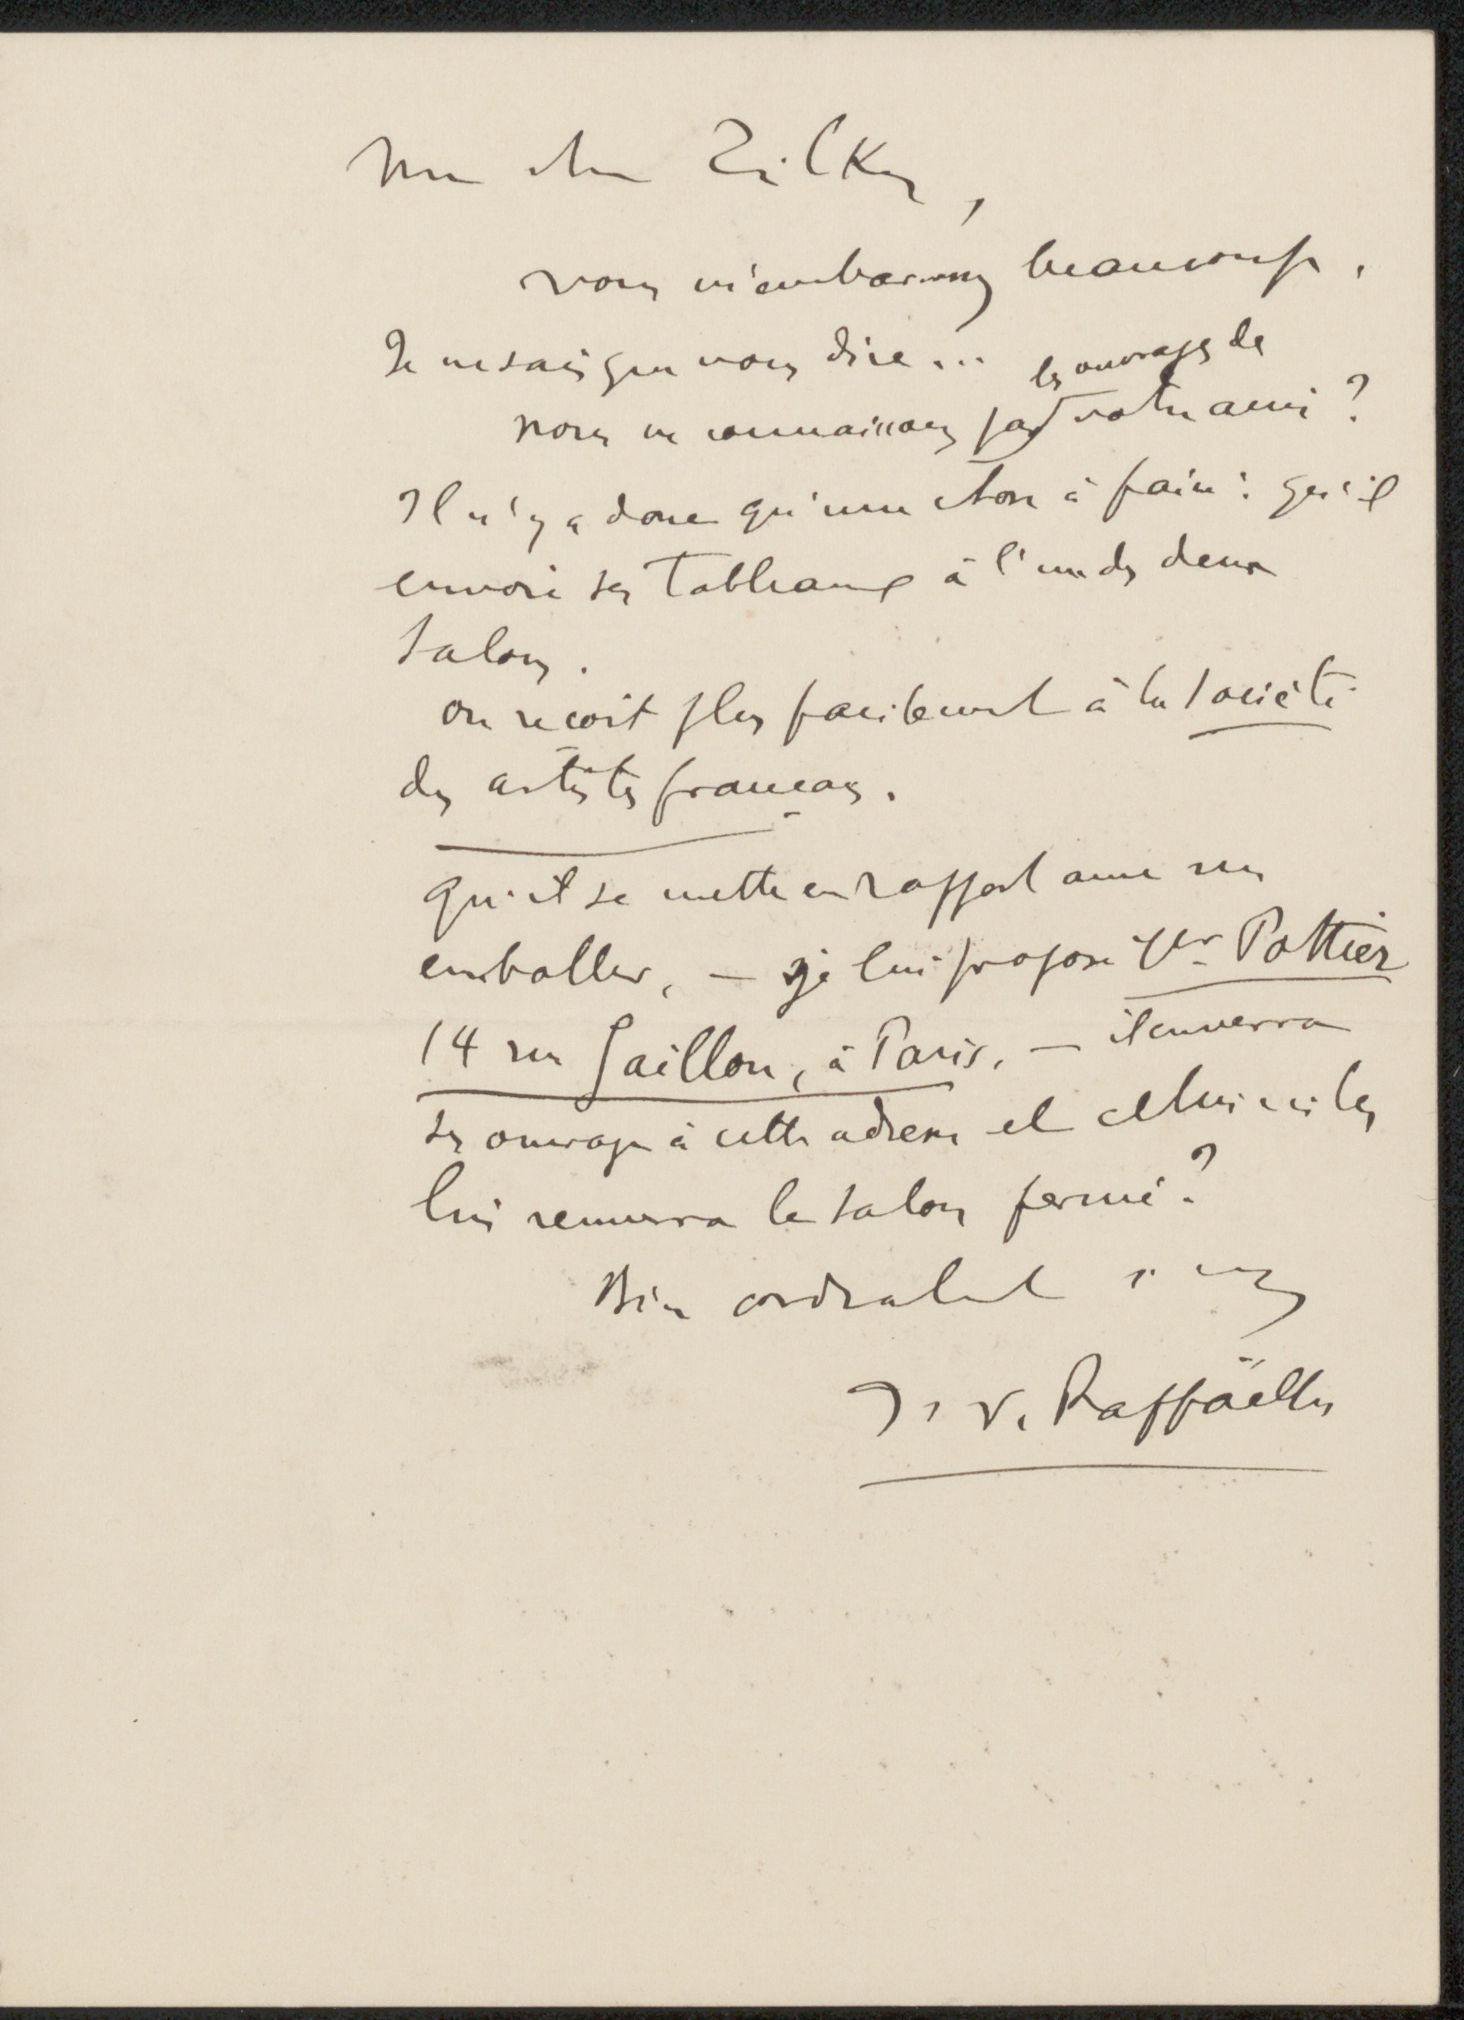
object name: letter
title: Brief aan Philip Zilcken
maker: jean françois raffaëlli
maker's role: print maker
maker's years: 1850-1924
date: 1867-1924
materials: ink, paper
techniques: pen, writing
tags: the hague, painter, draughtsman, philip zilcken, painting (including book-illumination, miniature-painting), exhibition ~ art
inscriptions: collector's mark: ‘RPK’